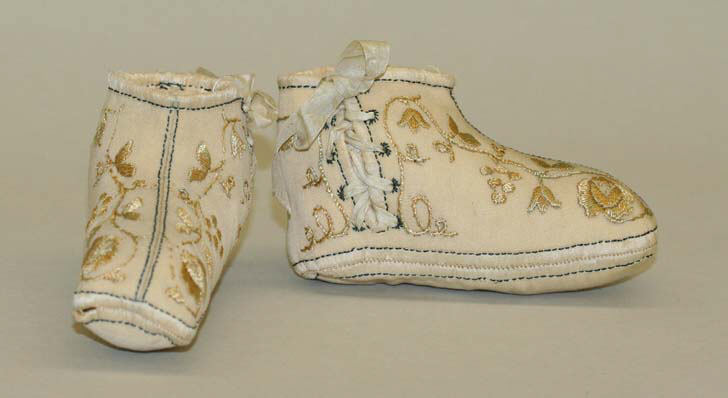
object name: bootee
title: Bootees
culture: american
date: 1834-1866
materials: silk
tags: flowers